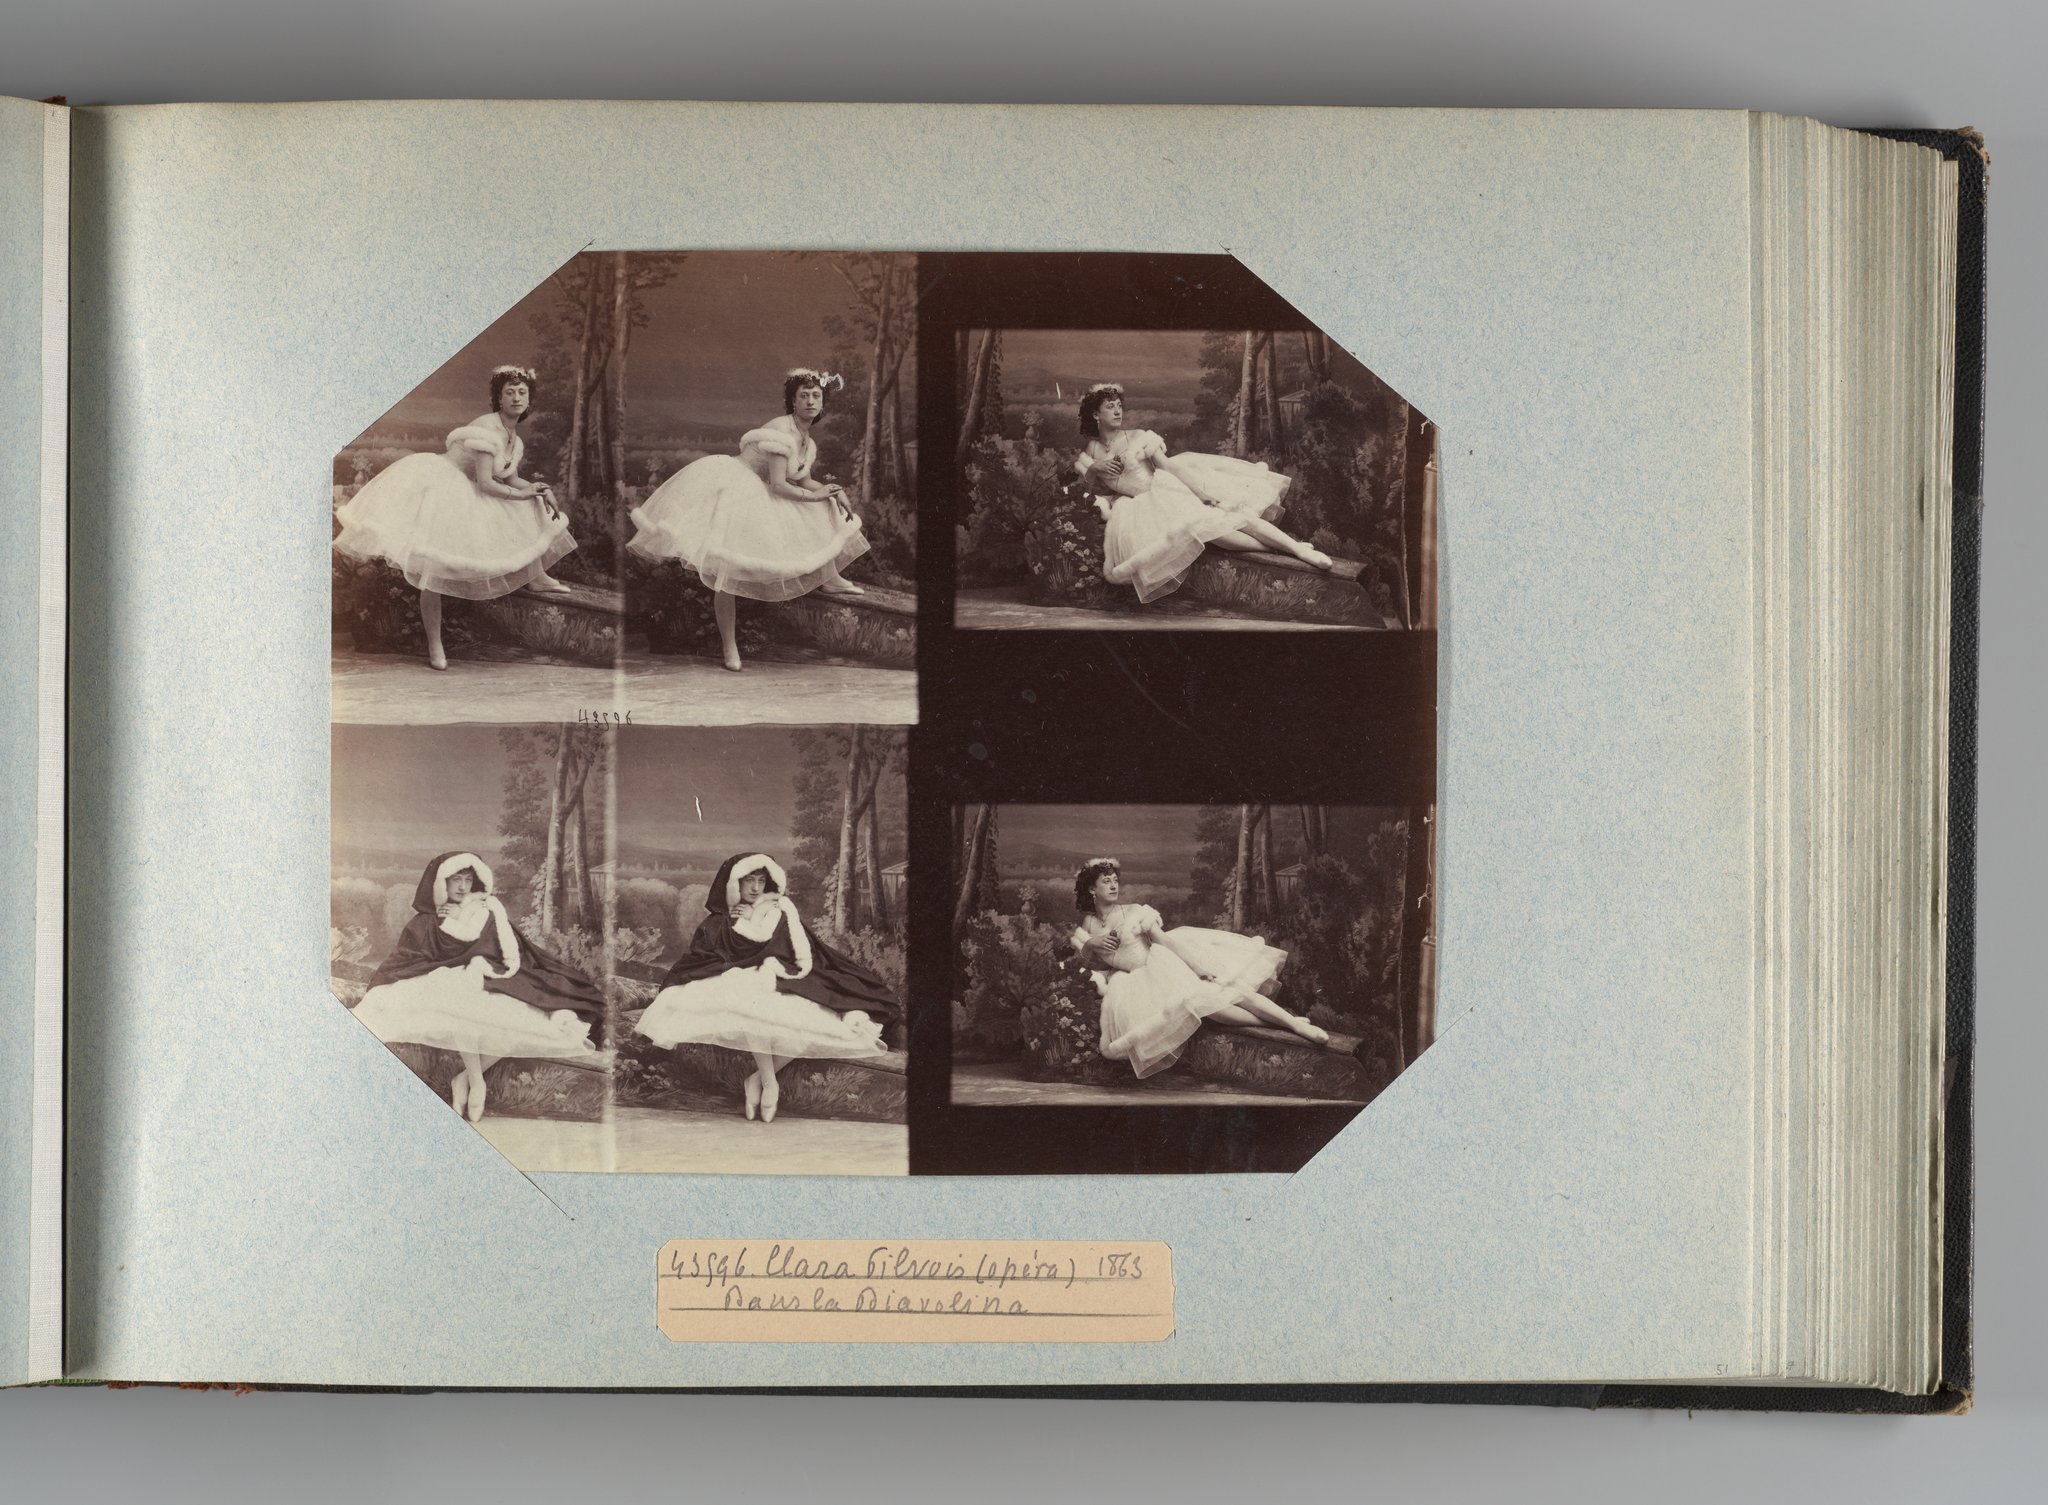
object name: photograph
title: Clara Pilvois dans le Diavolina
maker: andré-adolphe-eugène disdéri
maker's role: artist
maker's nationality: french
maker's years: 1819-1889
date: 1863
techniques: albumen silver print, glass negative